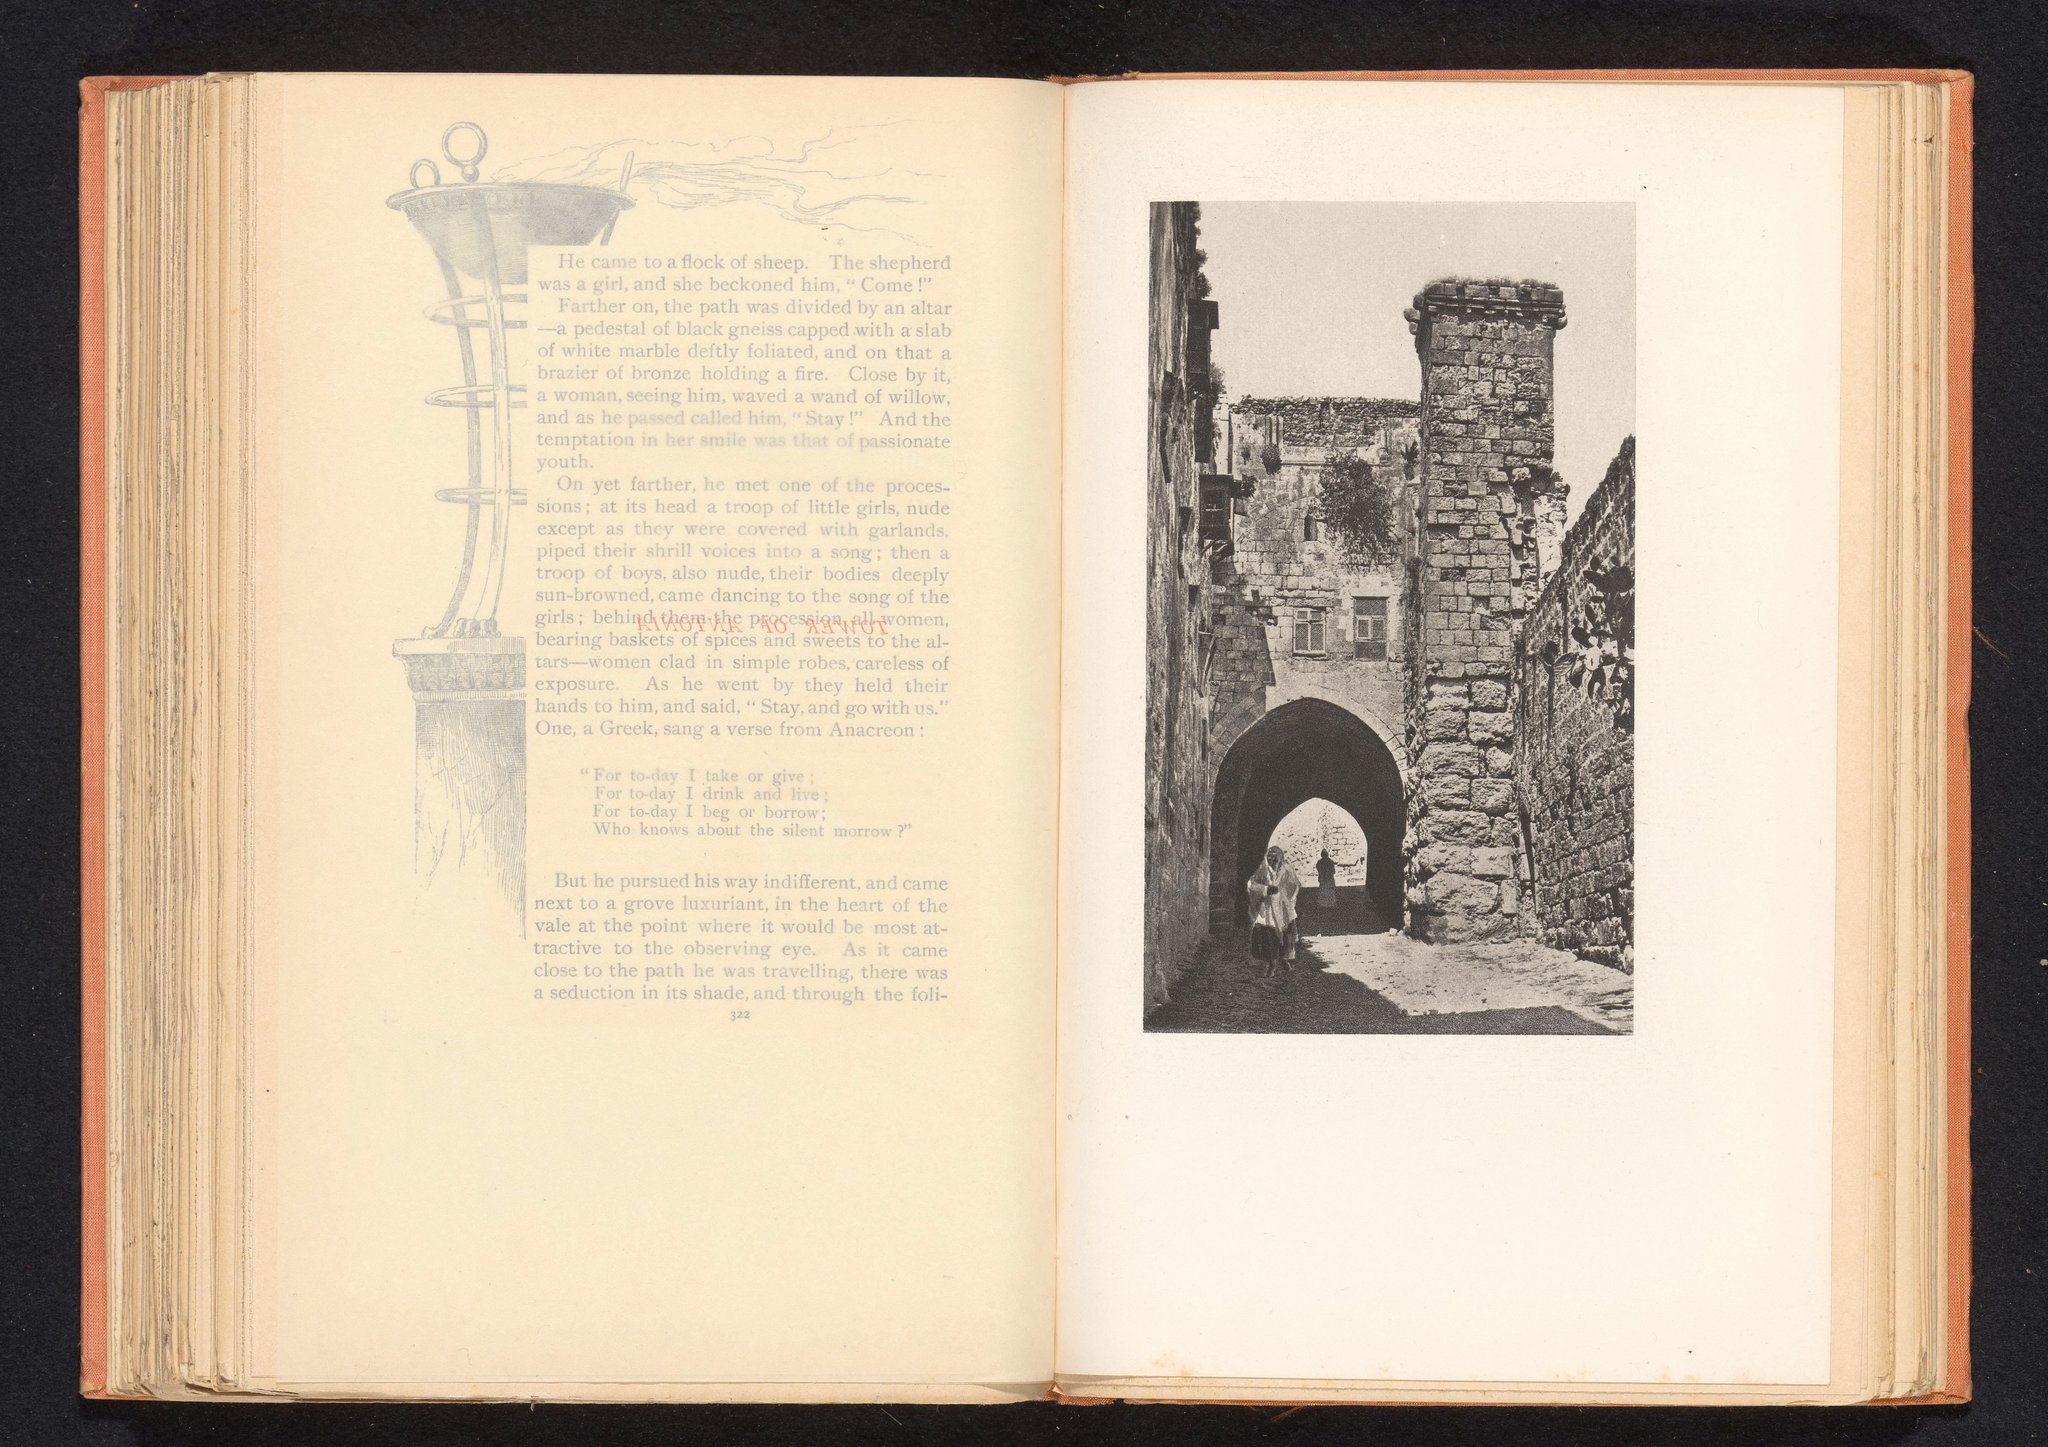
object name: page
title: Tower of Antonia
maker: Anonymous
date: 1882-1892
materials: paper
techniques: photoaquatint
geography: jerusalem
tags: tower (of house or building)